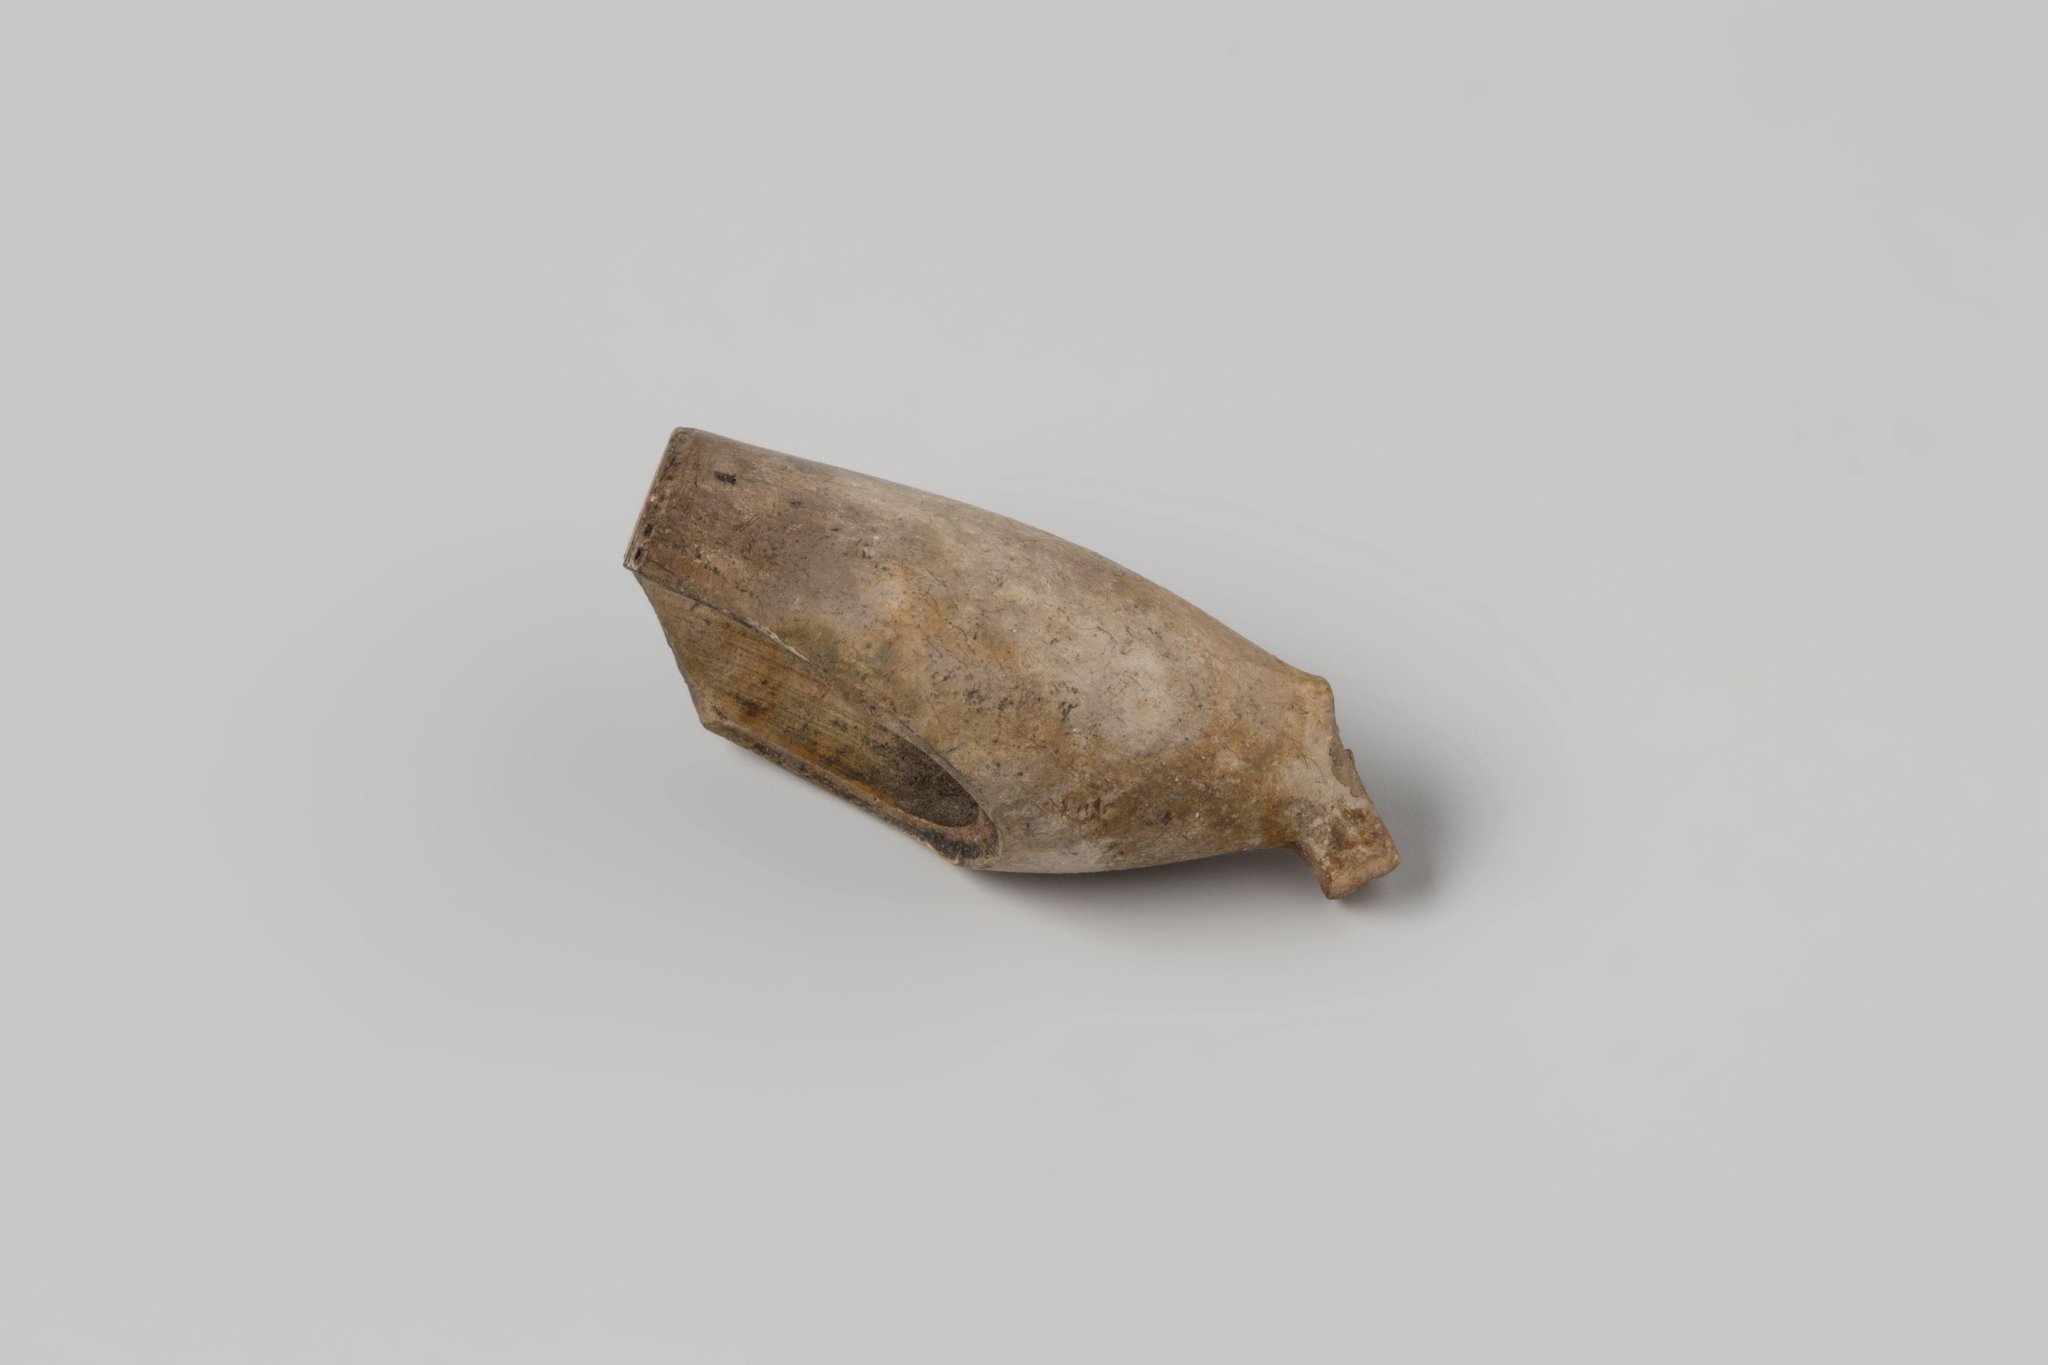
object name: pipe bowl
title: Fragment pijpenkop uit het wrak van de Oost-Indiëvaarder Hollandia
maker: Anonymous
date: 1700-1743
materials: clay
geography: netherlands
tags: verenigde oostindische compagnie, hollandia (schip), annet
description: Pipe, bowl, heelmark: crowned 82; fragment, no hsm.